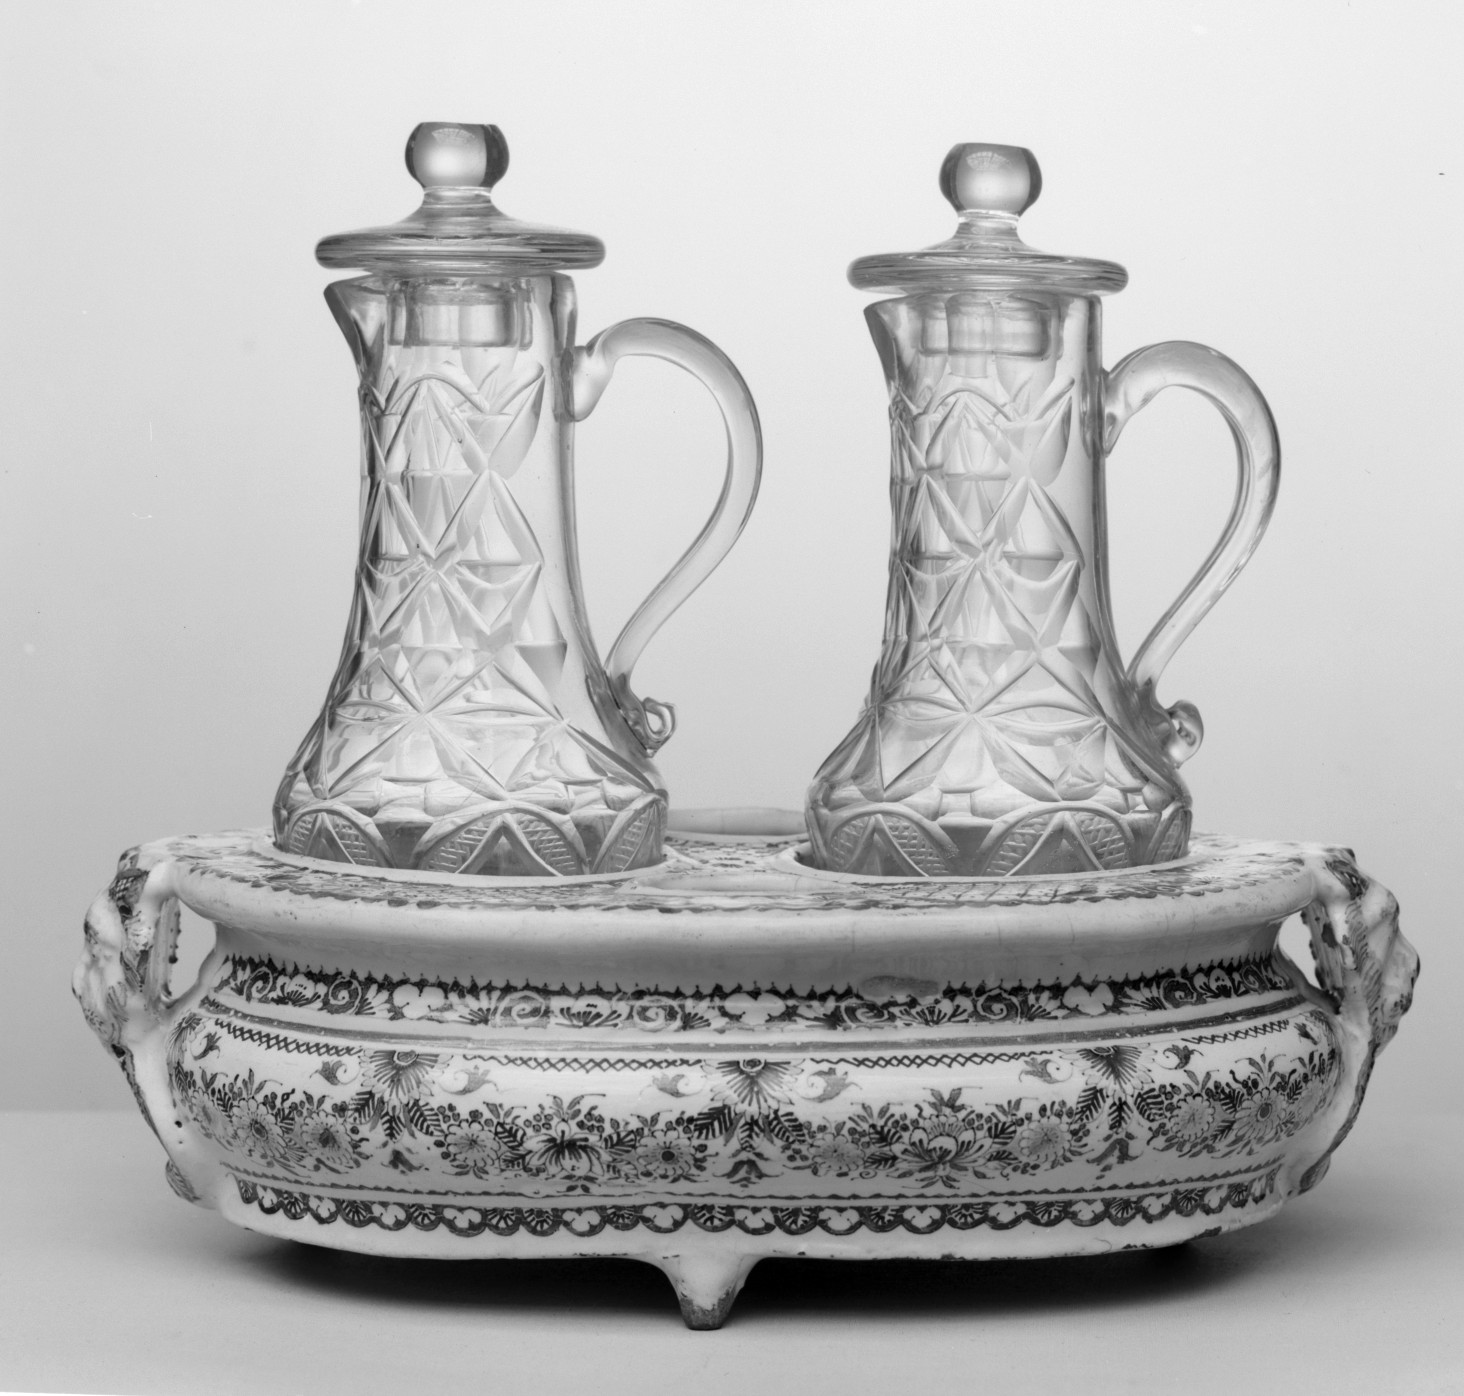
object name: cruet stand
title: Cruet stand with cruets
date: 1705-1720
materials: faience, glass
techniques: glazing